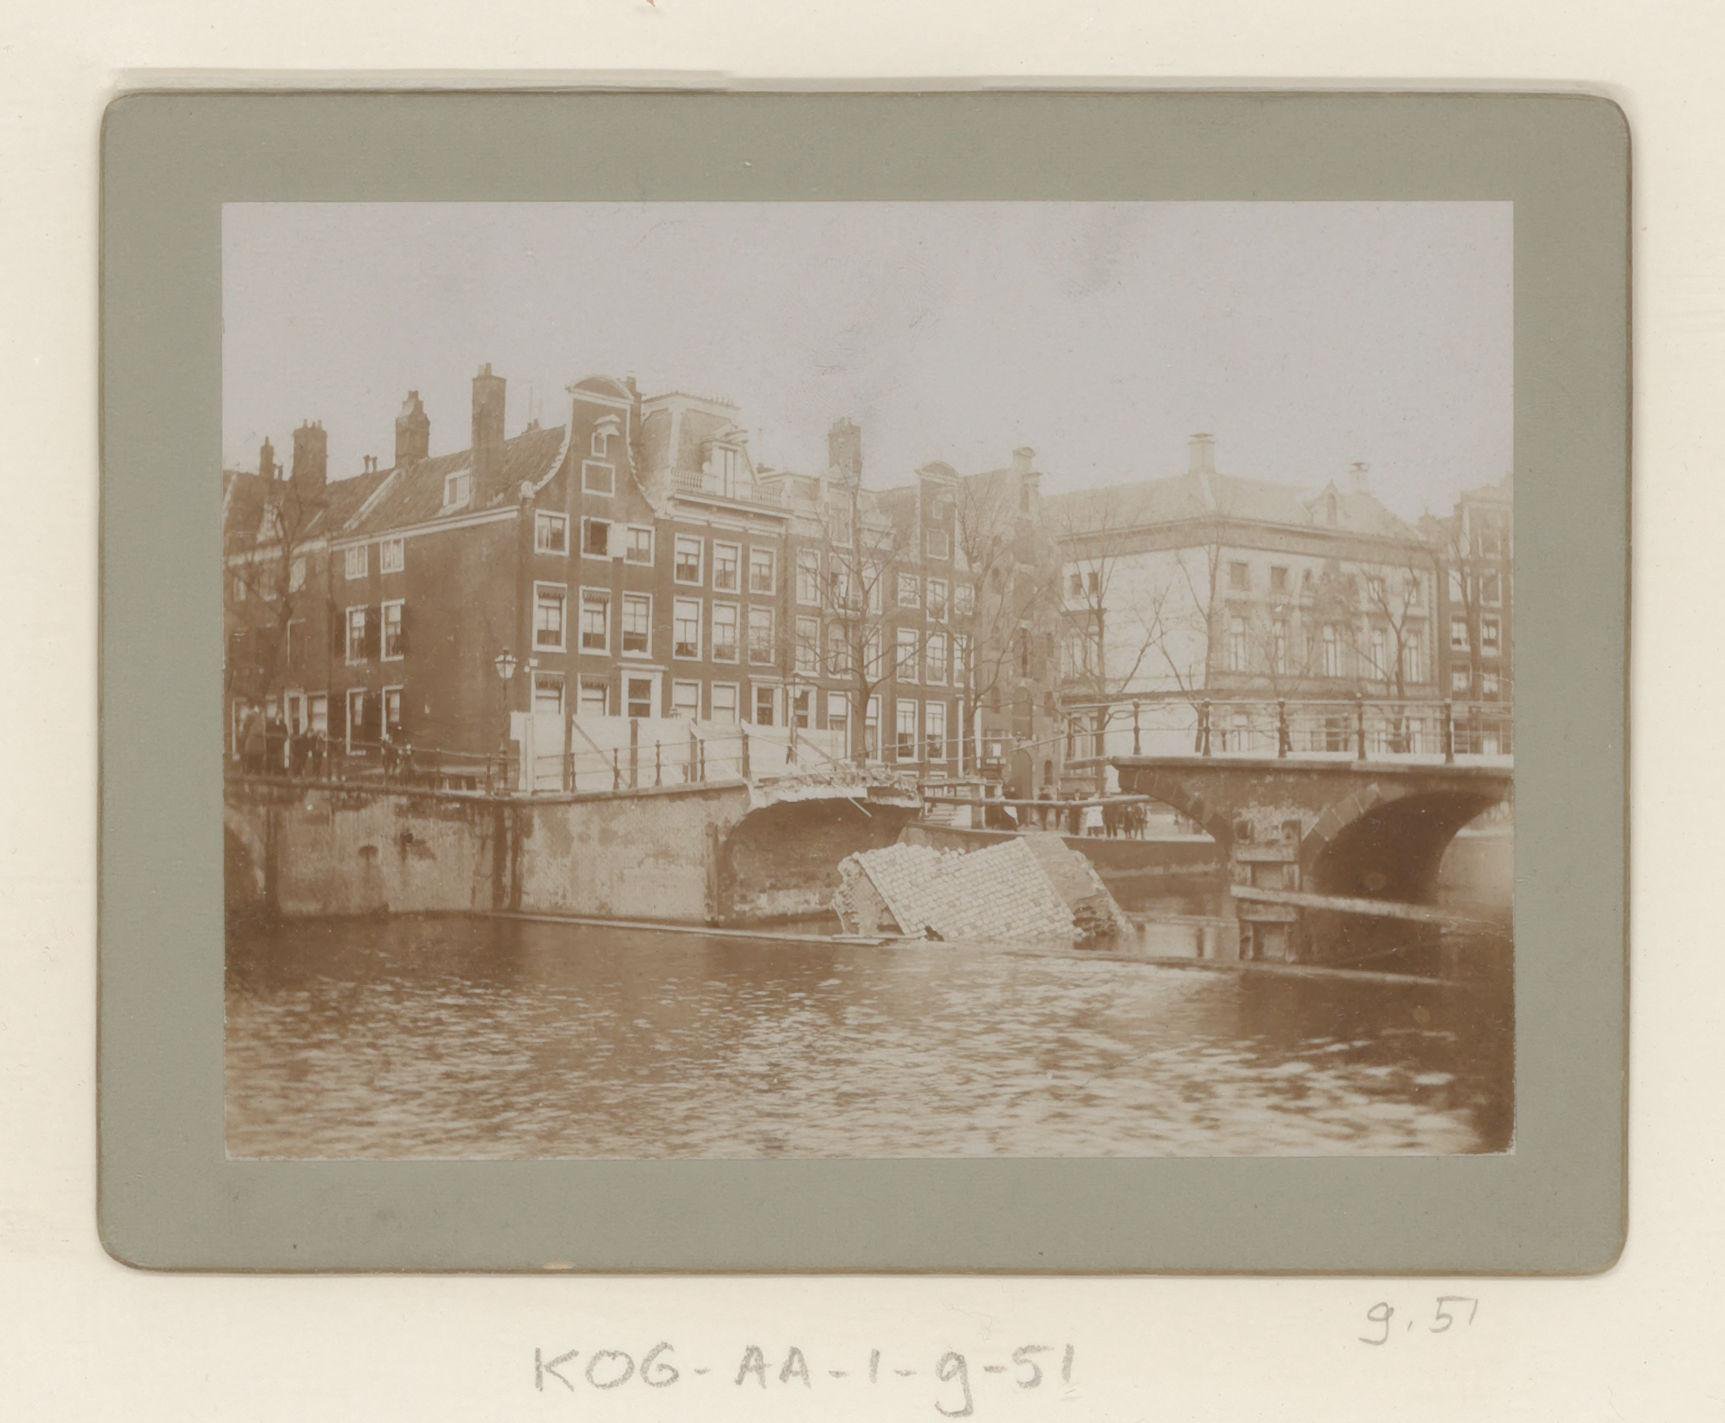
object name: cabinet photograph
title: Gezicht op een deels ingestorte brug over de Keizersgracht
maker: Anonymous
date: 1865-1940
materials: paper, cardboard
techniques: collodion silver print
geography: amsterdam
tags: city-view in general; 'veduta', canal, bridge in city across river, canal, etc.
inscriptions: collector's mark: ‘9 51’ Lugt 1641b, inscription: ‘Ingestort stuk van / Sluis Keizergr. bi Leijdschegr. / Am 1895 / 23/3 1906?’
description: Onderwerpsrubriek binnen de Atlas Amsterdam: Kadijksplein, Karthuizerkerkhof, Kattegat, Kattenburg, Kapelsteeg O.Z., Enge Kerksteeg, Kerkstraat, Kinkerstraat, Kolk O.Z., Koningsplein, Kromboomsloot [Krom Boomssloot], Kostverlorenkade, Kwakersdwarspad, Kalverstraat, Keizersgracht (v.d. Brouwersgracht – Amstel), Klerensloot (Gedempte), Klimopstraat, Kloveniersburgwal, Kraansluis.